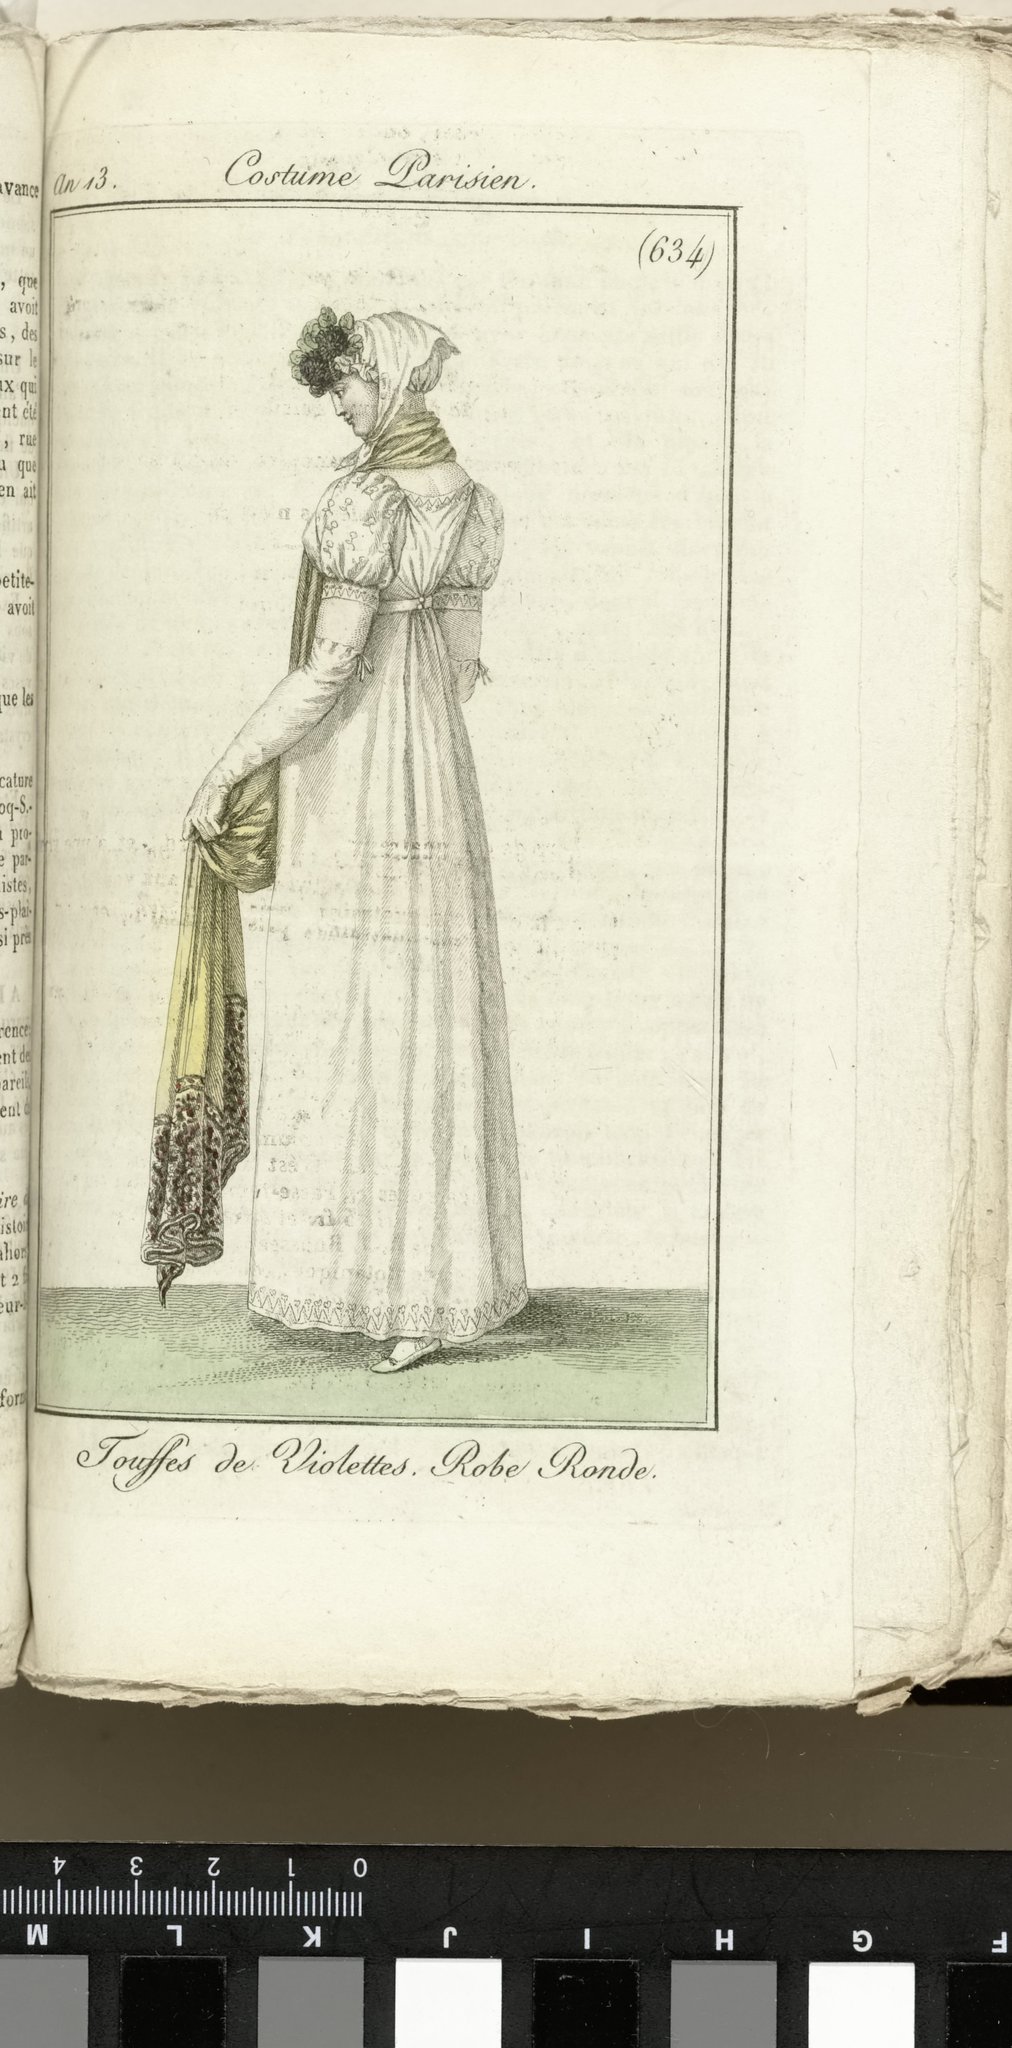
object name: fashion print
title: Journal des Dames et des Modes, Costume Parisien, 1805, An 13 (634) Touffes de Violettes. Robe Ronde.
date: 1805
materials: paper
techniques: engraving, hand coloring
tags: gloves, mittens (long gloves) (+ women's clothes), head-gear (headscarf) (+ women's clothes), neck-gear ~ clothing (shawl) (+ women's clothes), head-gear: cap (+ women's clothes), fashion plates, dress, gown (+ women's clothes)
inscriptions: title: ‘Touffes de Violettes. Robe ronde.’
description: Witte japon met korte pofmouwen, met enkellange rok. Gele lange geborduurde sjaal. Lange handschoenen en witte platte schoenen. Mutsje op het hoofd, waarover een wit hoofddoekje.